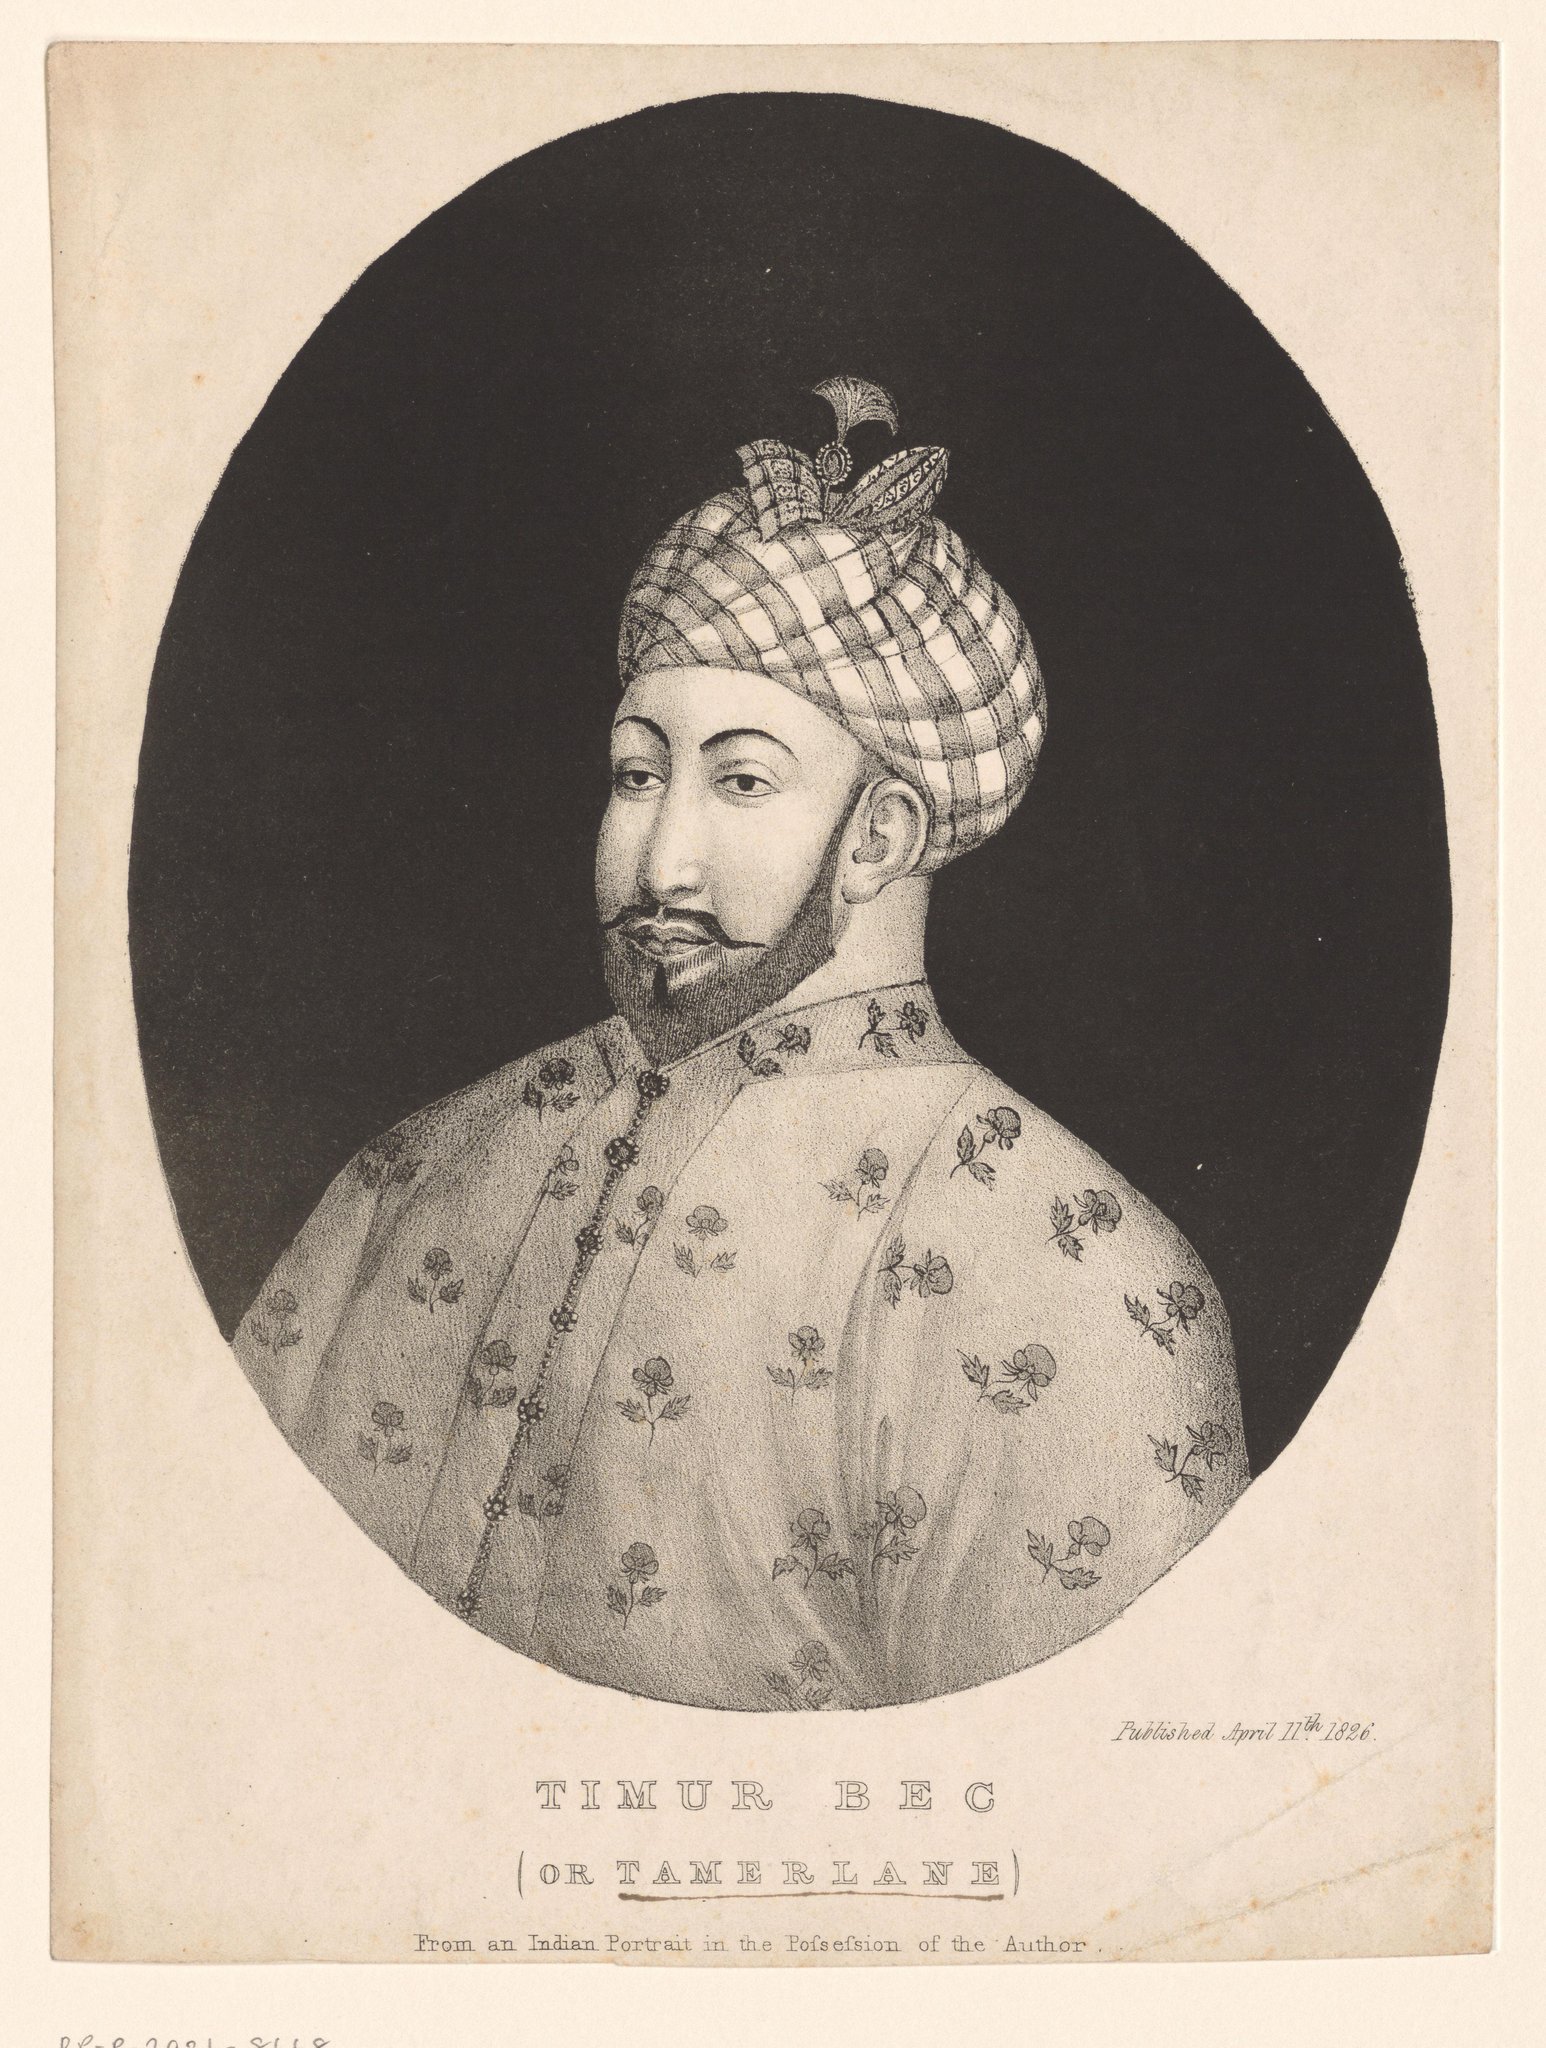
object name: print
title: Portret van Timoer Lenk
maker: Anonymous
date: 1826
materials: paper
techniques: lithograph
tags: commander-in-chief, general, marshal, historical persons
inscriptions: date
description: Prent uit: Ranking, John. Historical Researches on the Wars and Sports of the Mongols and Romans (...). Londen: voor de auteur, 1826.